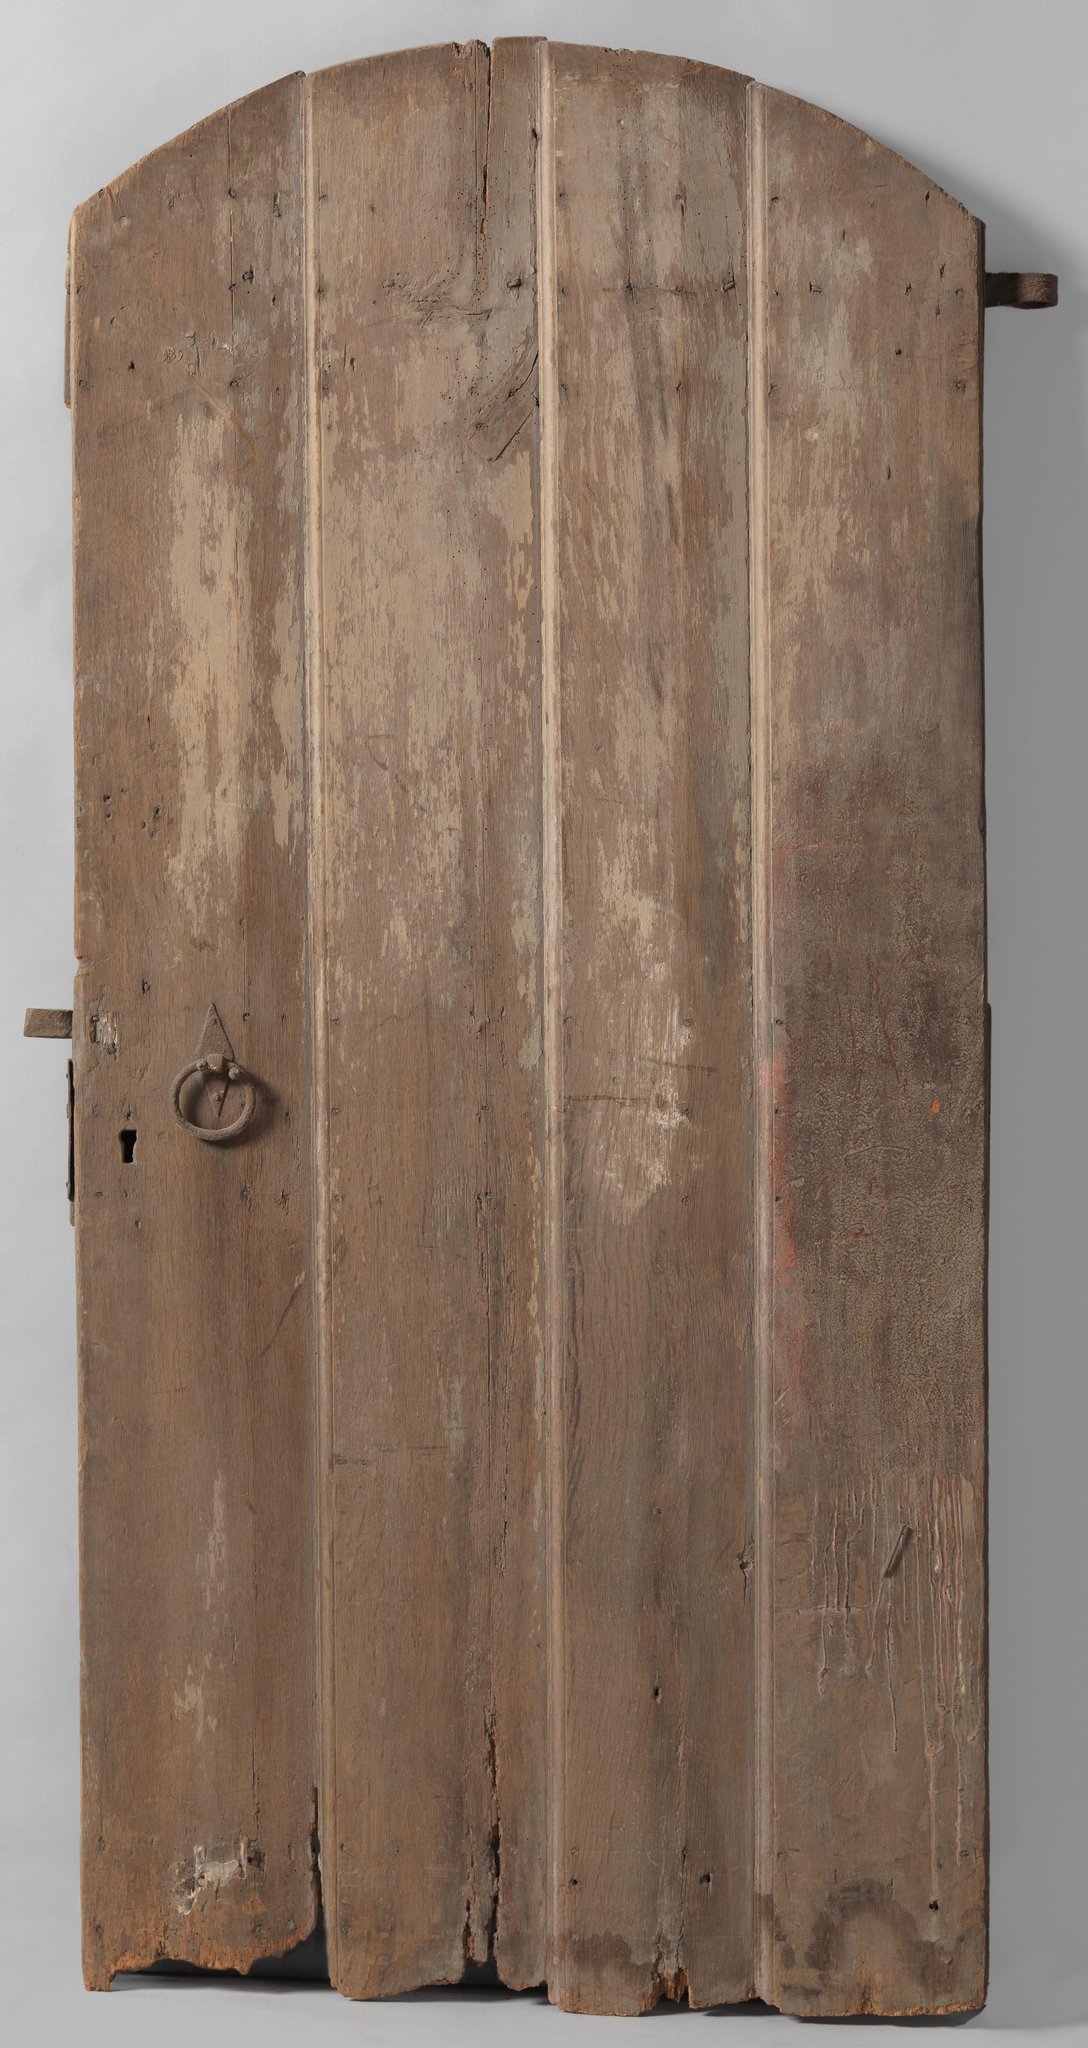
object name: architectural element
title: Deur, bestaande uit vier planken, aan de achterzijde samengehouden door drie klampen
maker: Anonymous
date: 1600-1699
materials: iron, wood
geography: netherlands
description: Deur van eikenhout bestaande uit vier planken, die aan de achterzijde samengehouden worden door drie liggende klampen. Zij zijn voorzien van een ijzeren grendel met ring en twee hengselscharnieren. De deur is van boven afgerond. Zie tevens: BK-TN-1609-a.